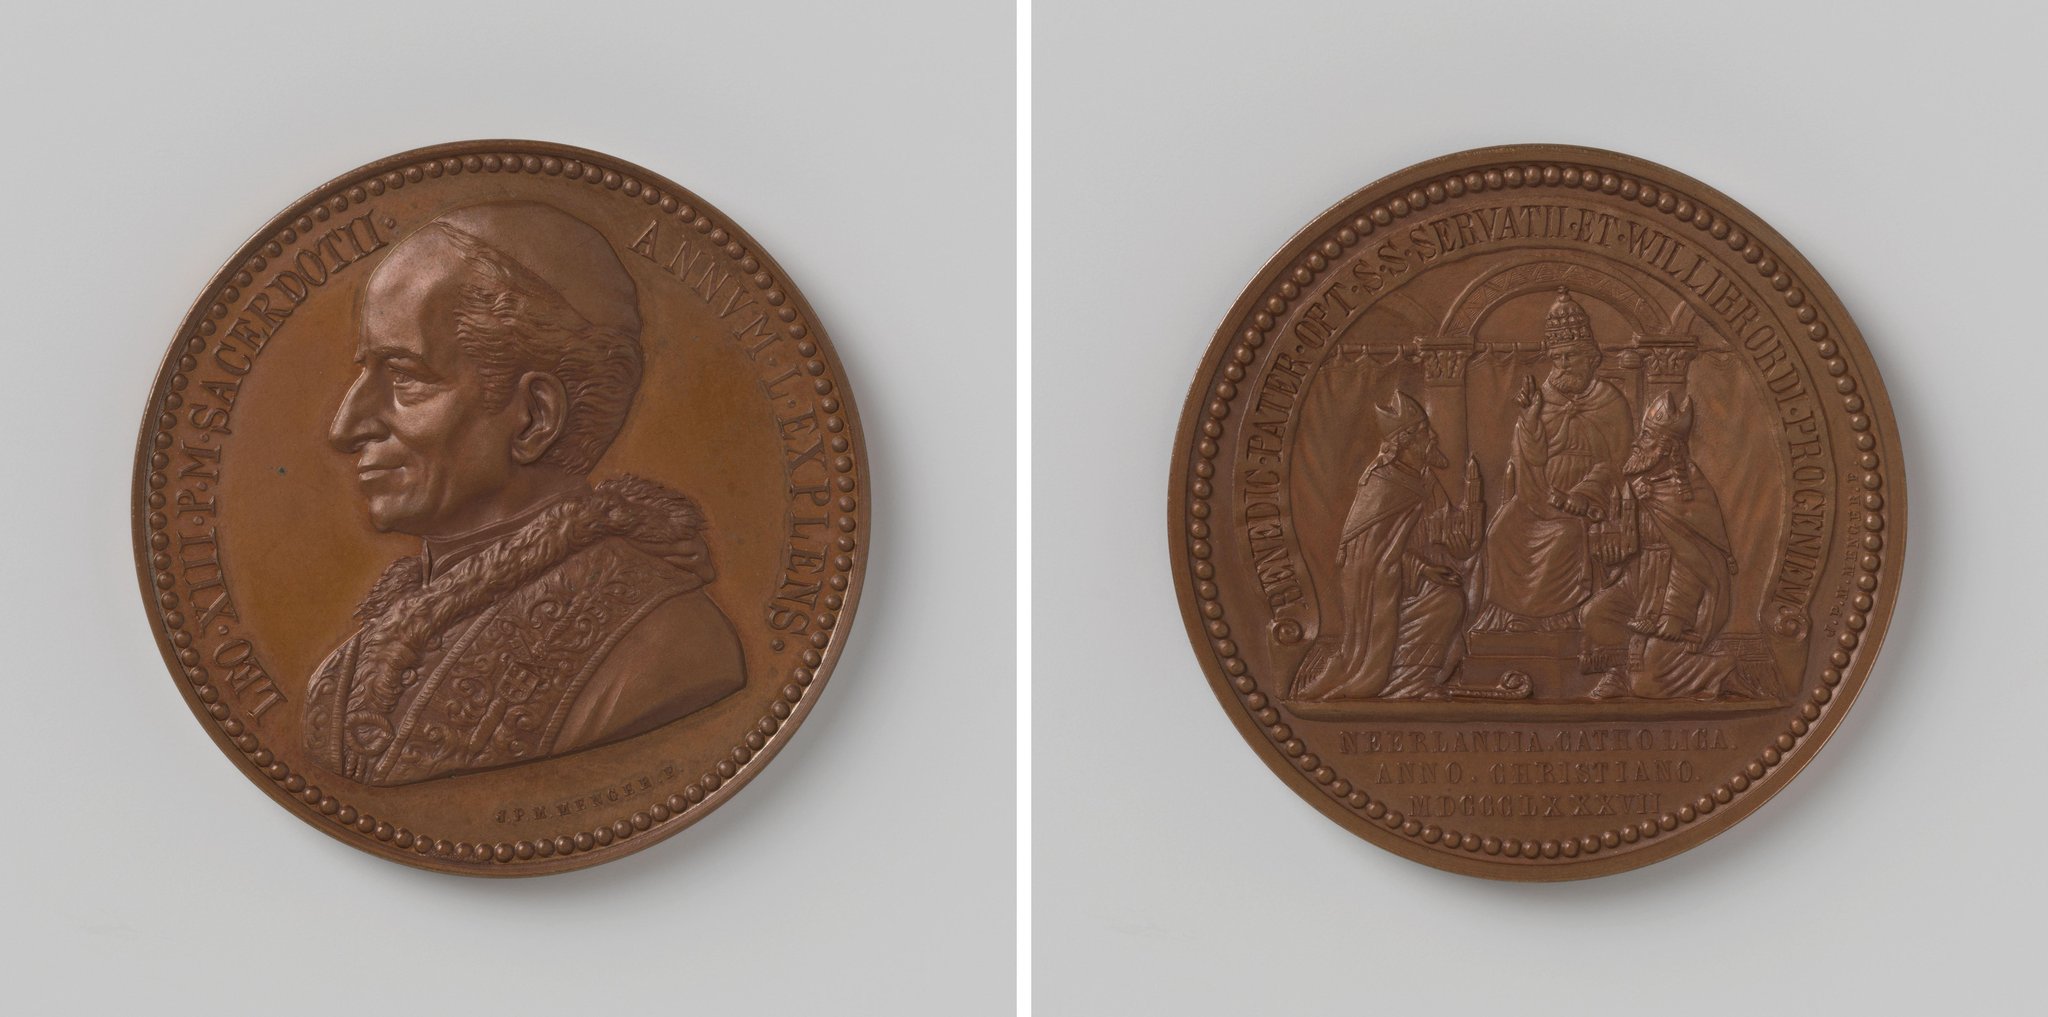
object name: history medal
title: Viering van het vijftigjarig priesterschap van paus Leo XIII in Nederland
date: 1887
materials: bronze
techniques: striking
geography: utrecht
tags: rome, leo xiii, netherlands, italy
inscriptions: date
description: Bronzen penning. Voorzijde: borstbeeld van de paus in profiel naar links + randschrift: LEO. XIII. P. M. SACERDOTII. ANNVM. L. EXPLENS. Keerzijde: De paus op een troon gezeten, tussen 2 knielende bisschoppen, beiden met een kerkgebouw in de hand. De paus en de bisschop rechts hebben een sleutel in de linkerhand; op de grond vooraan ligt een bisschopsstaf. Randschrift en opschrift: BENEDIC . PATER. OPT. SS. SERVATII. ET. WILLIBRORDI. PROGENIEM. op afsnede: NEERLANDIA. CATHOLICA. / ANNO. CHRISTI. ANO. / MDCCCLXXXVII. Gemerkt Gesigneerd.